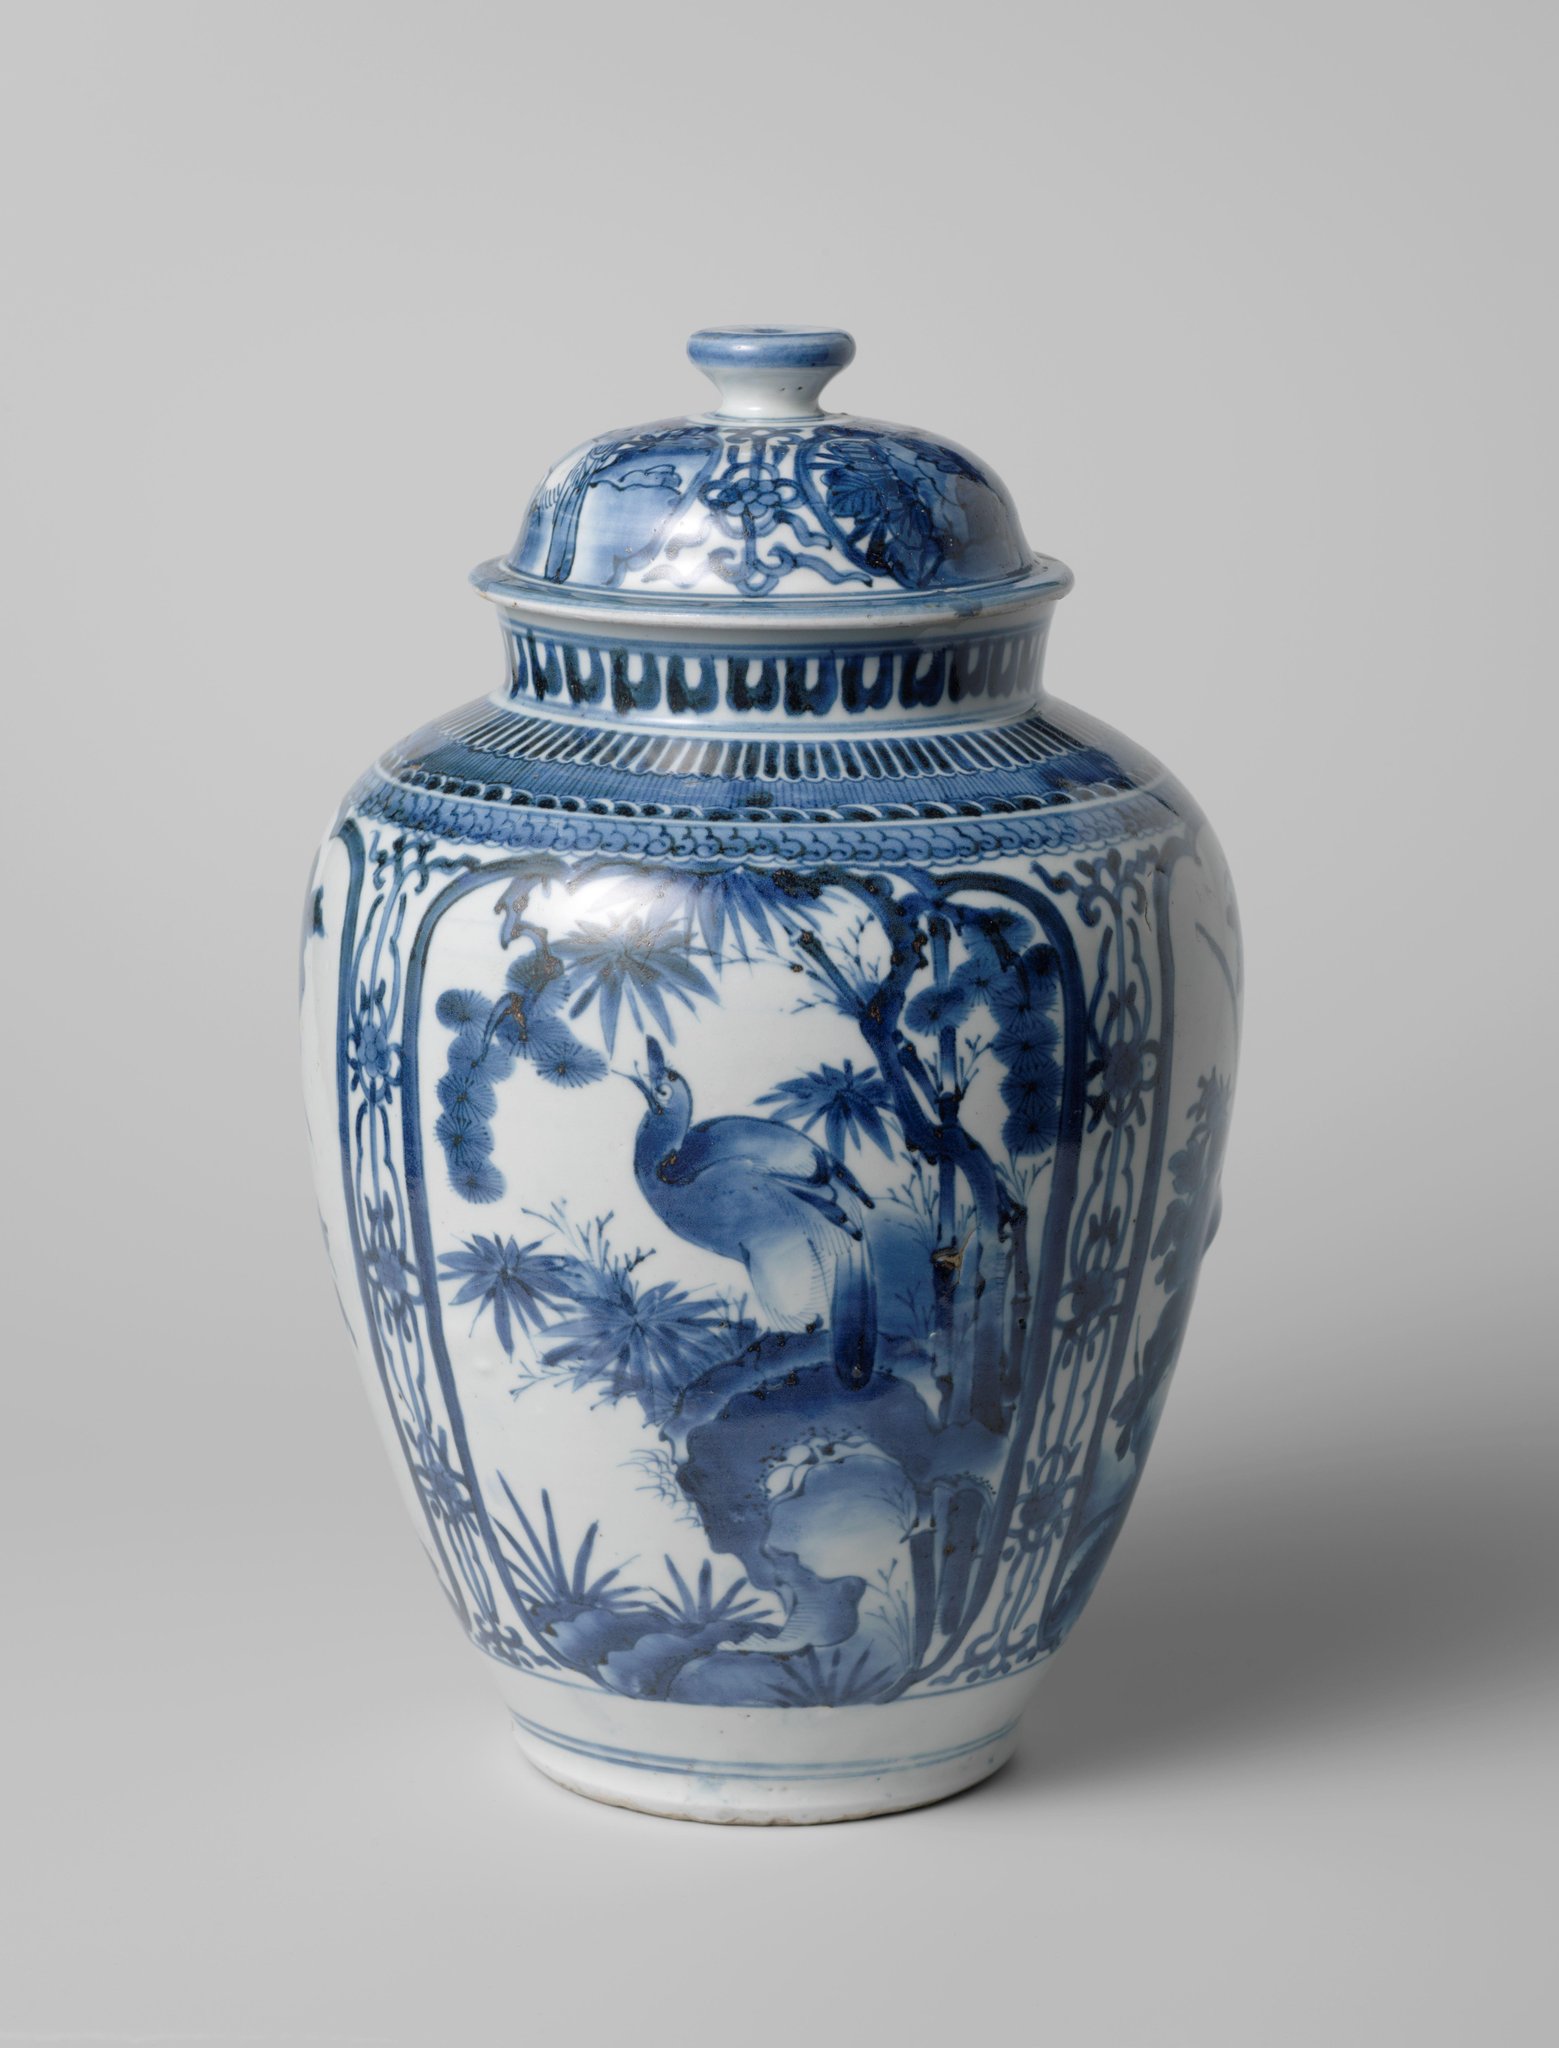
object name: lid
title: Ovoid covered jar with a bird on a rock and flowering plants in panels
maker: Anonymous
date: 1650-1680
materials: cobalt, glaze, paint, porcelain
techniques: firing, turning, vitrification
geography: japan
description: Deksel van eivormige dekselpot van porselein, beschilderd in onderglazuur blauw. Op de wand twee geschulpte cartouches met in één een vogel op een rots bij planten (pijnboom, bamboe), en in de andere een bloeiende plant (pioen) bij een rots. Tussen de cartouches gestileerde bloemranken. Op de knop een gestileerde bloem. De deksel met dezelfde decoratie. Deksel is gebroken geweest. Blauw-wit.